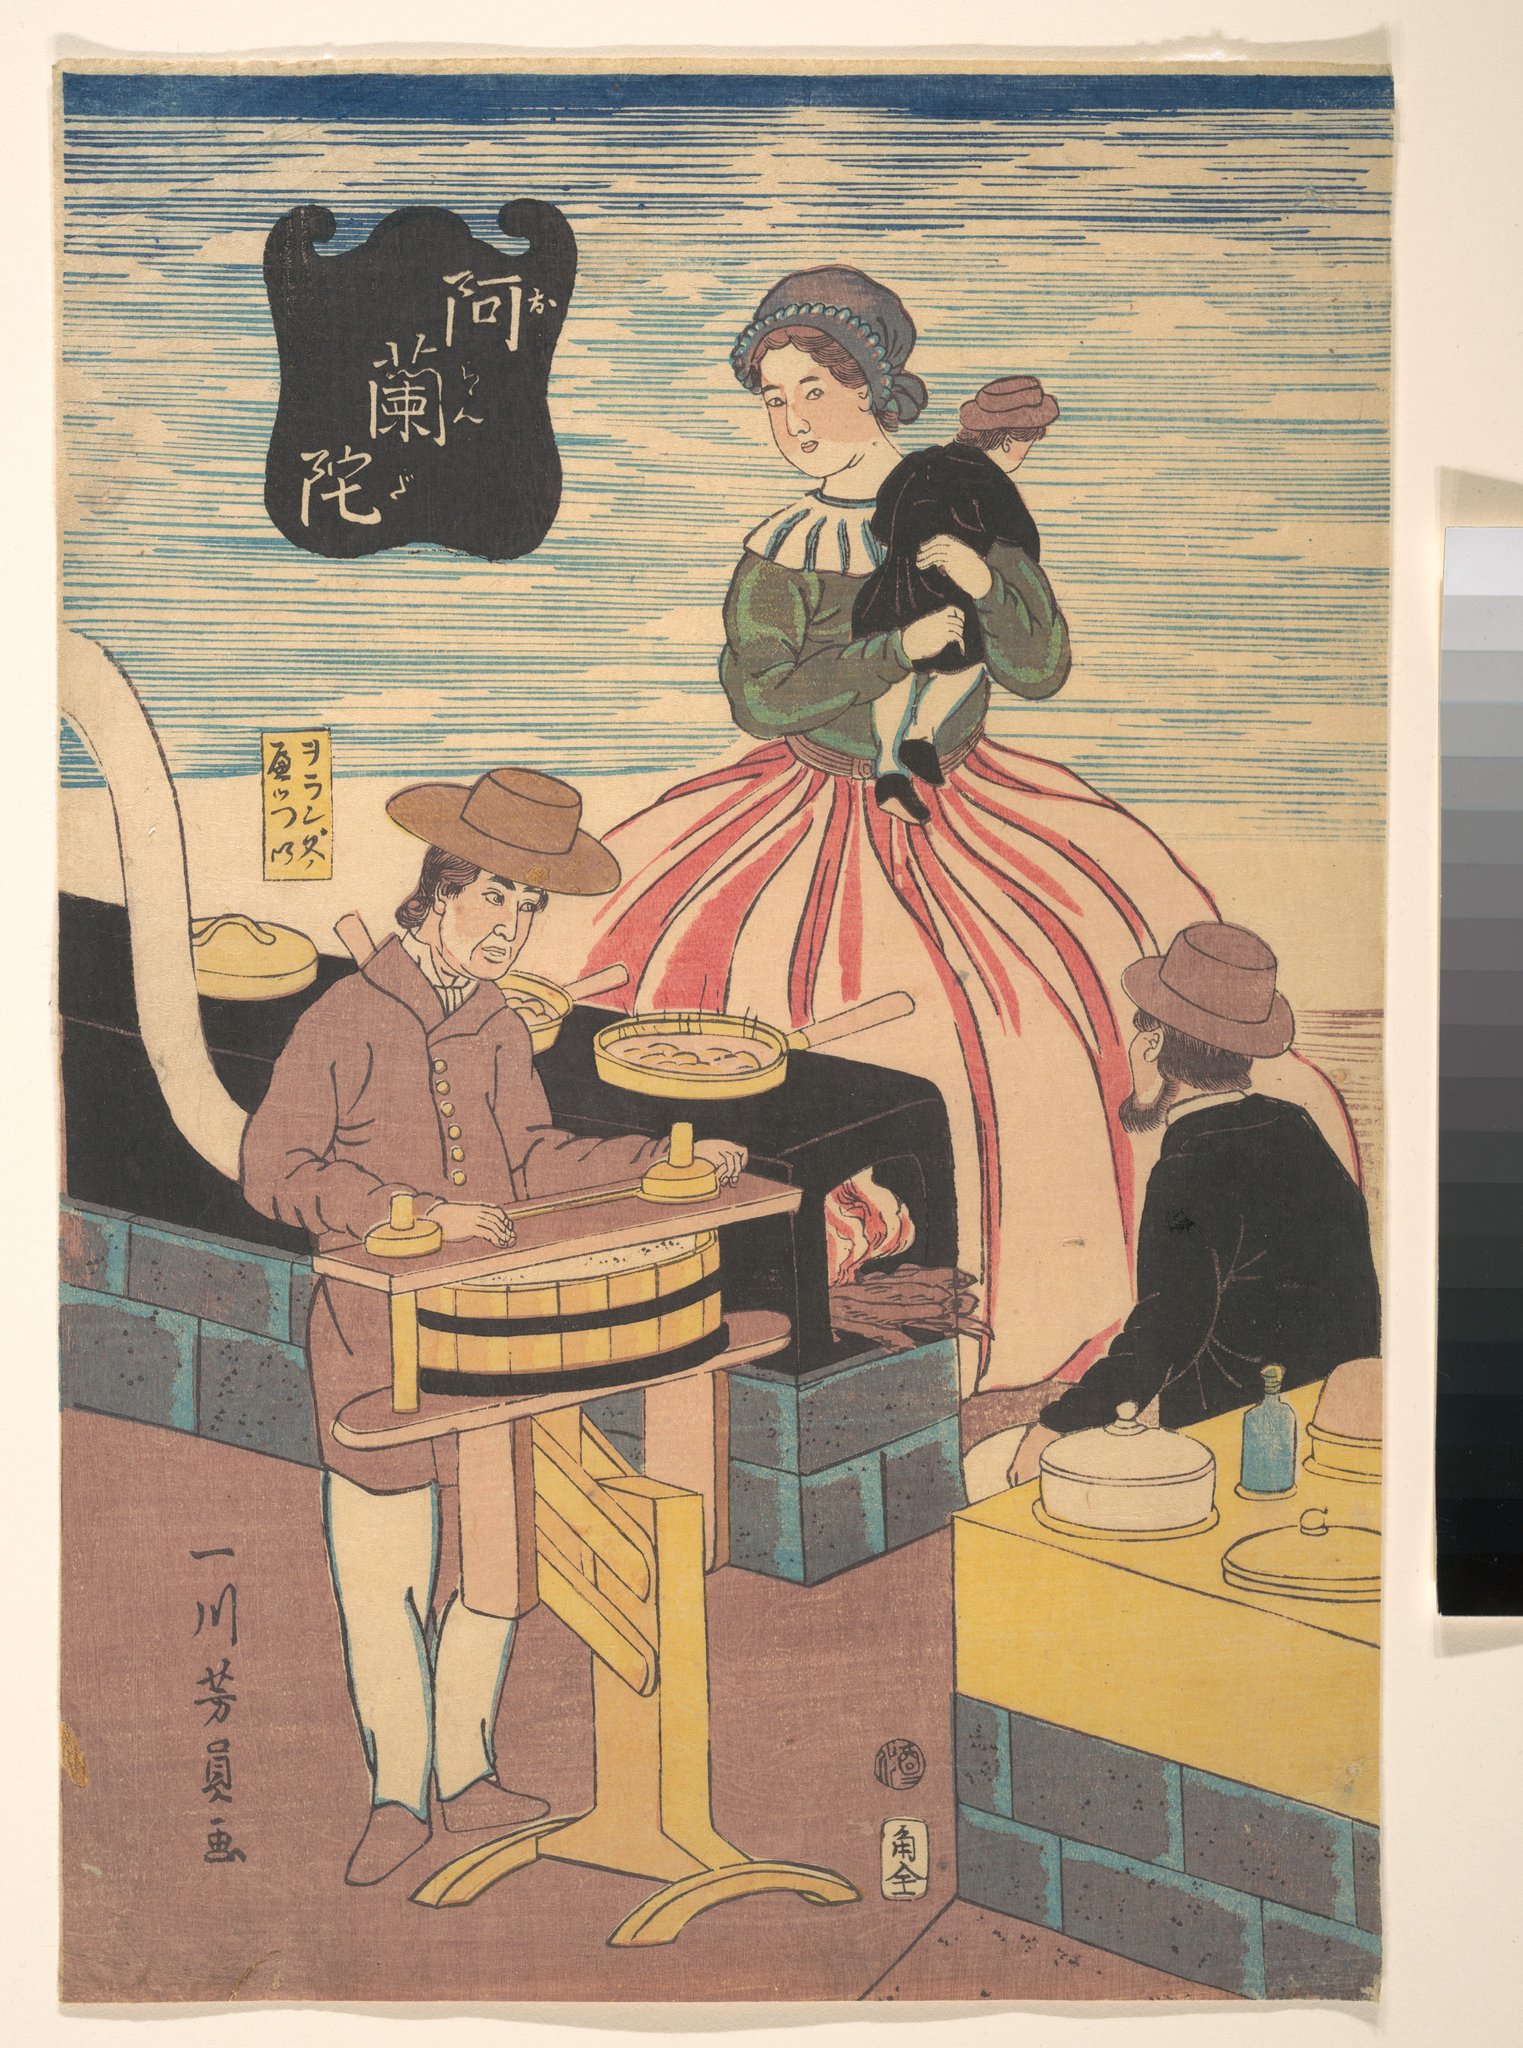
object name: woodblock print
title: A Dutch Group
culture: japanese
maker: utagawa yoshikazu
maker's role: artist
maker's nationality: japanese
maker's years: 1845-1870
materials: ink, paper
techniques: woodblock print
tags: children,men,women